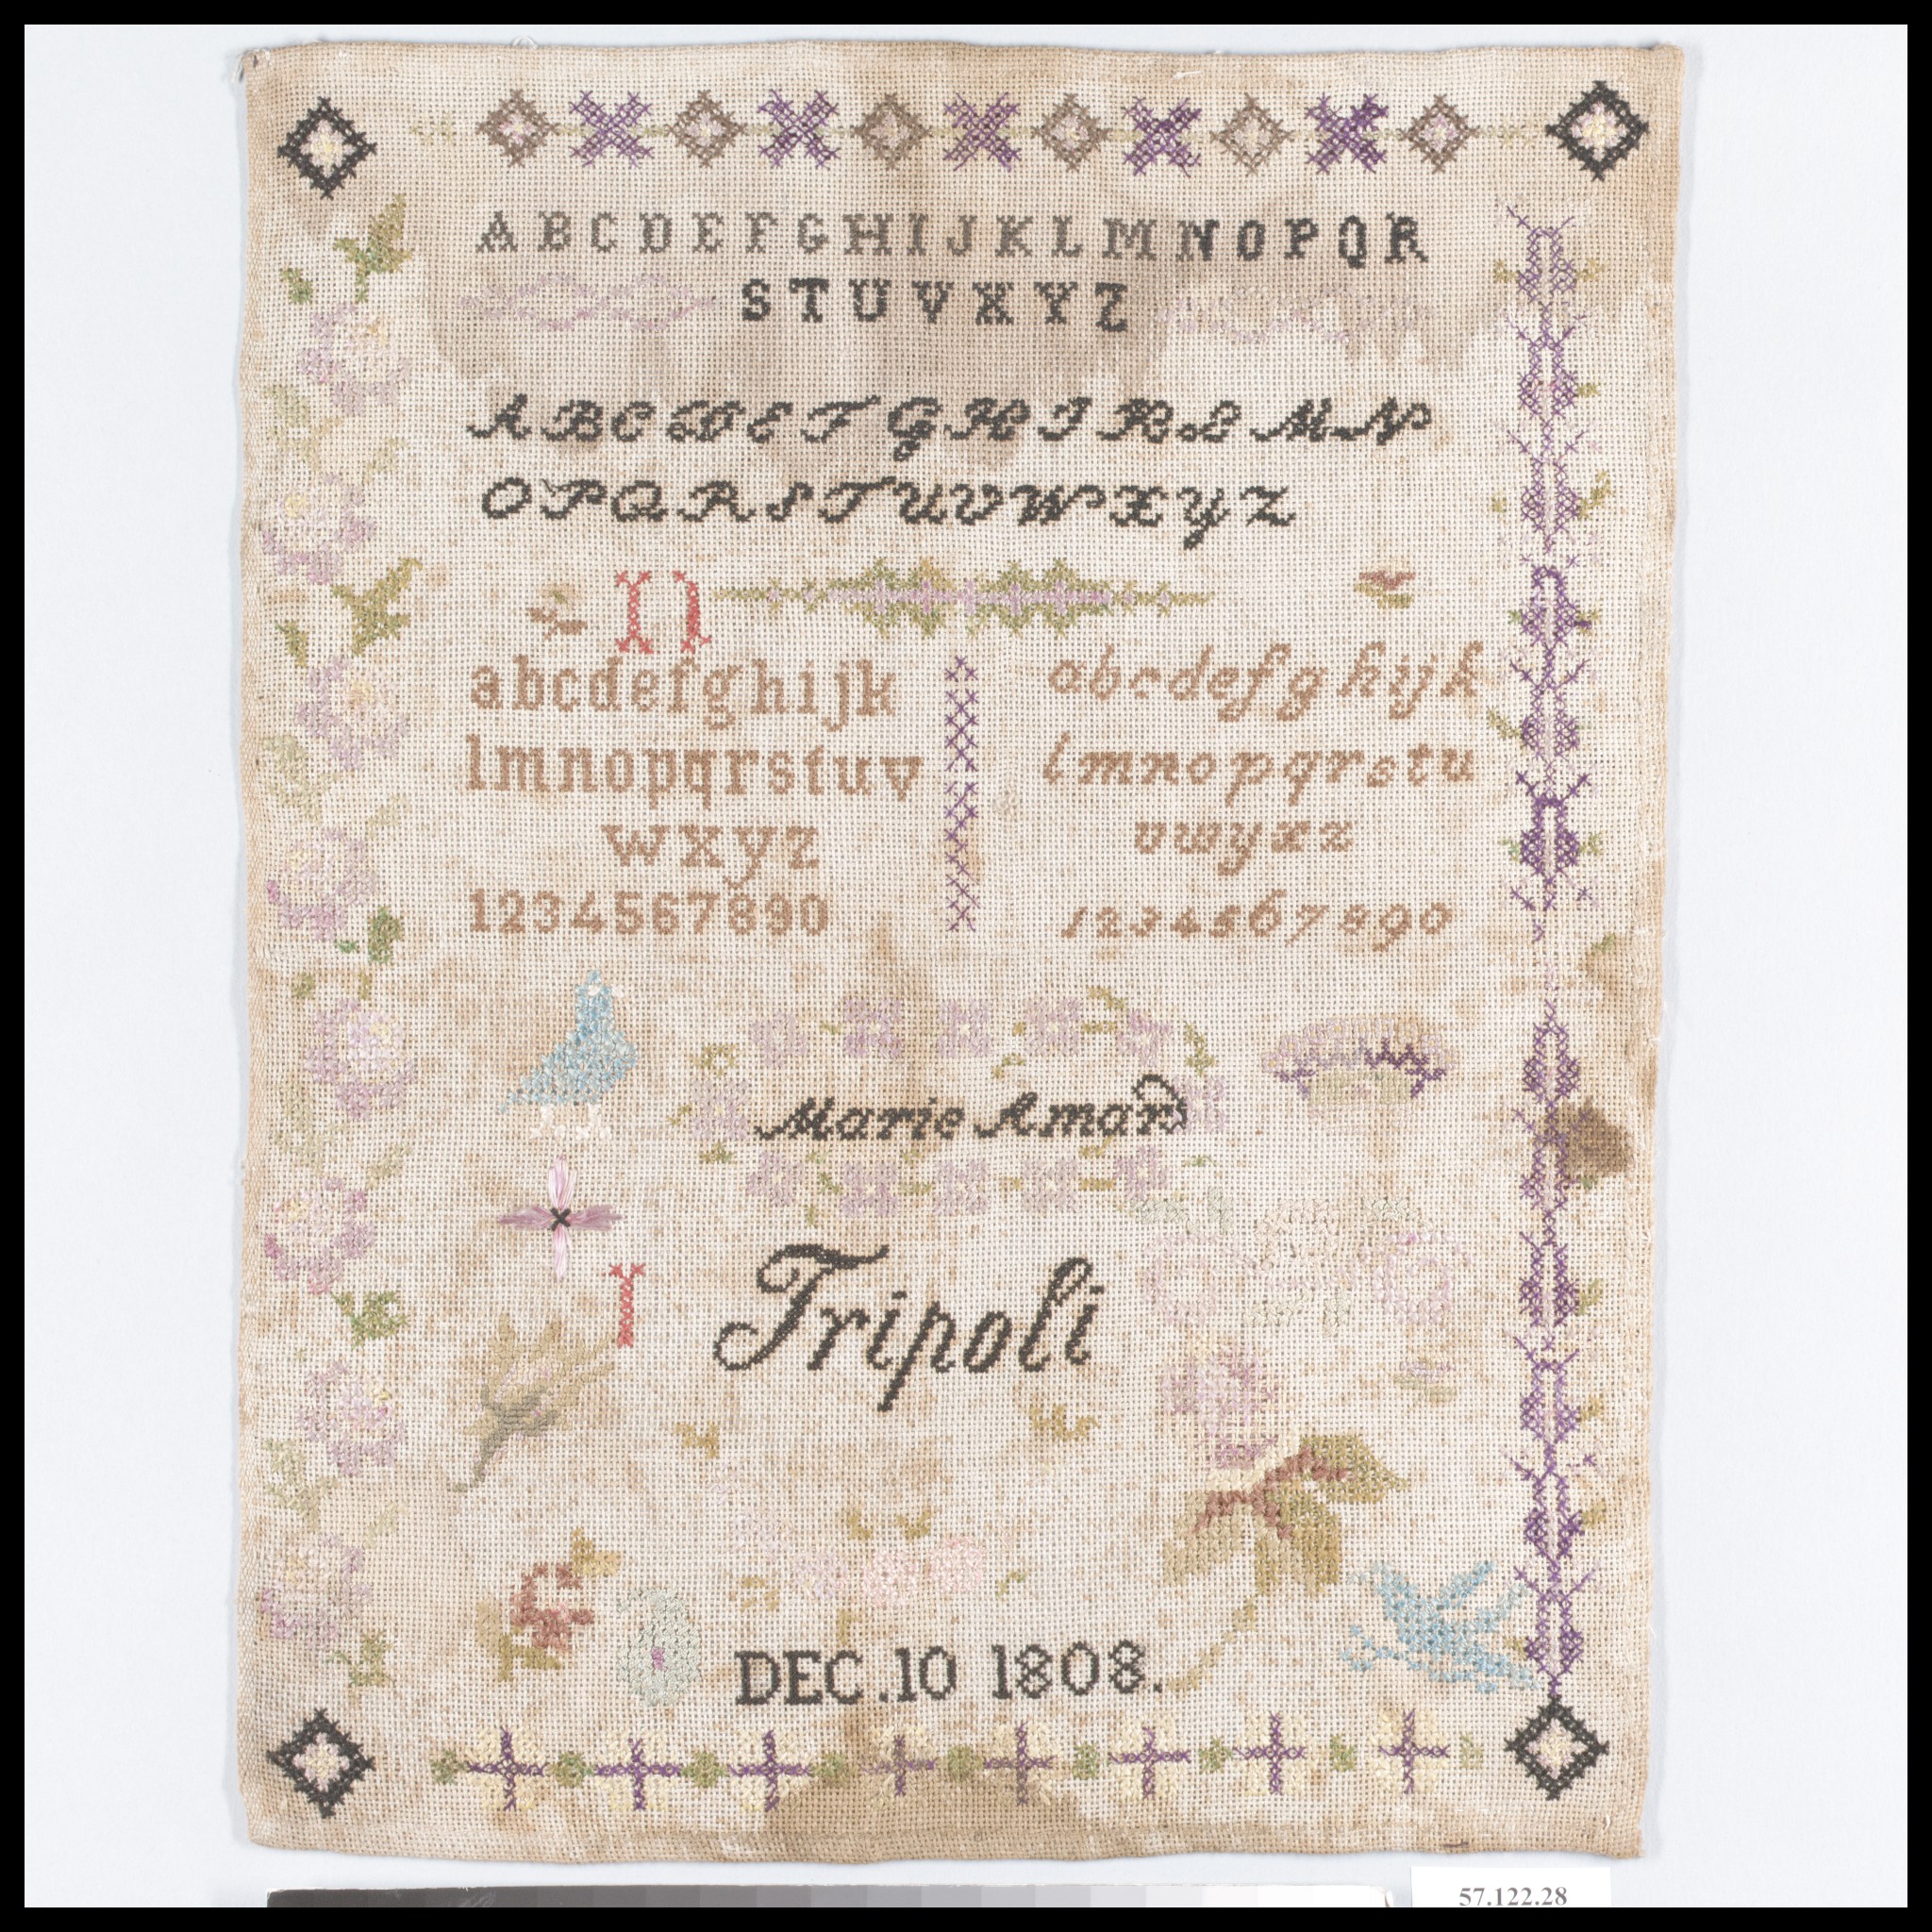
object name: sampler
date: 1808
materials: canvas, silk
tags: flowers